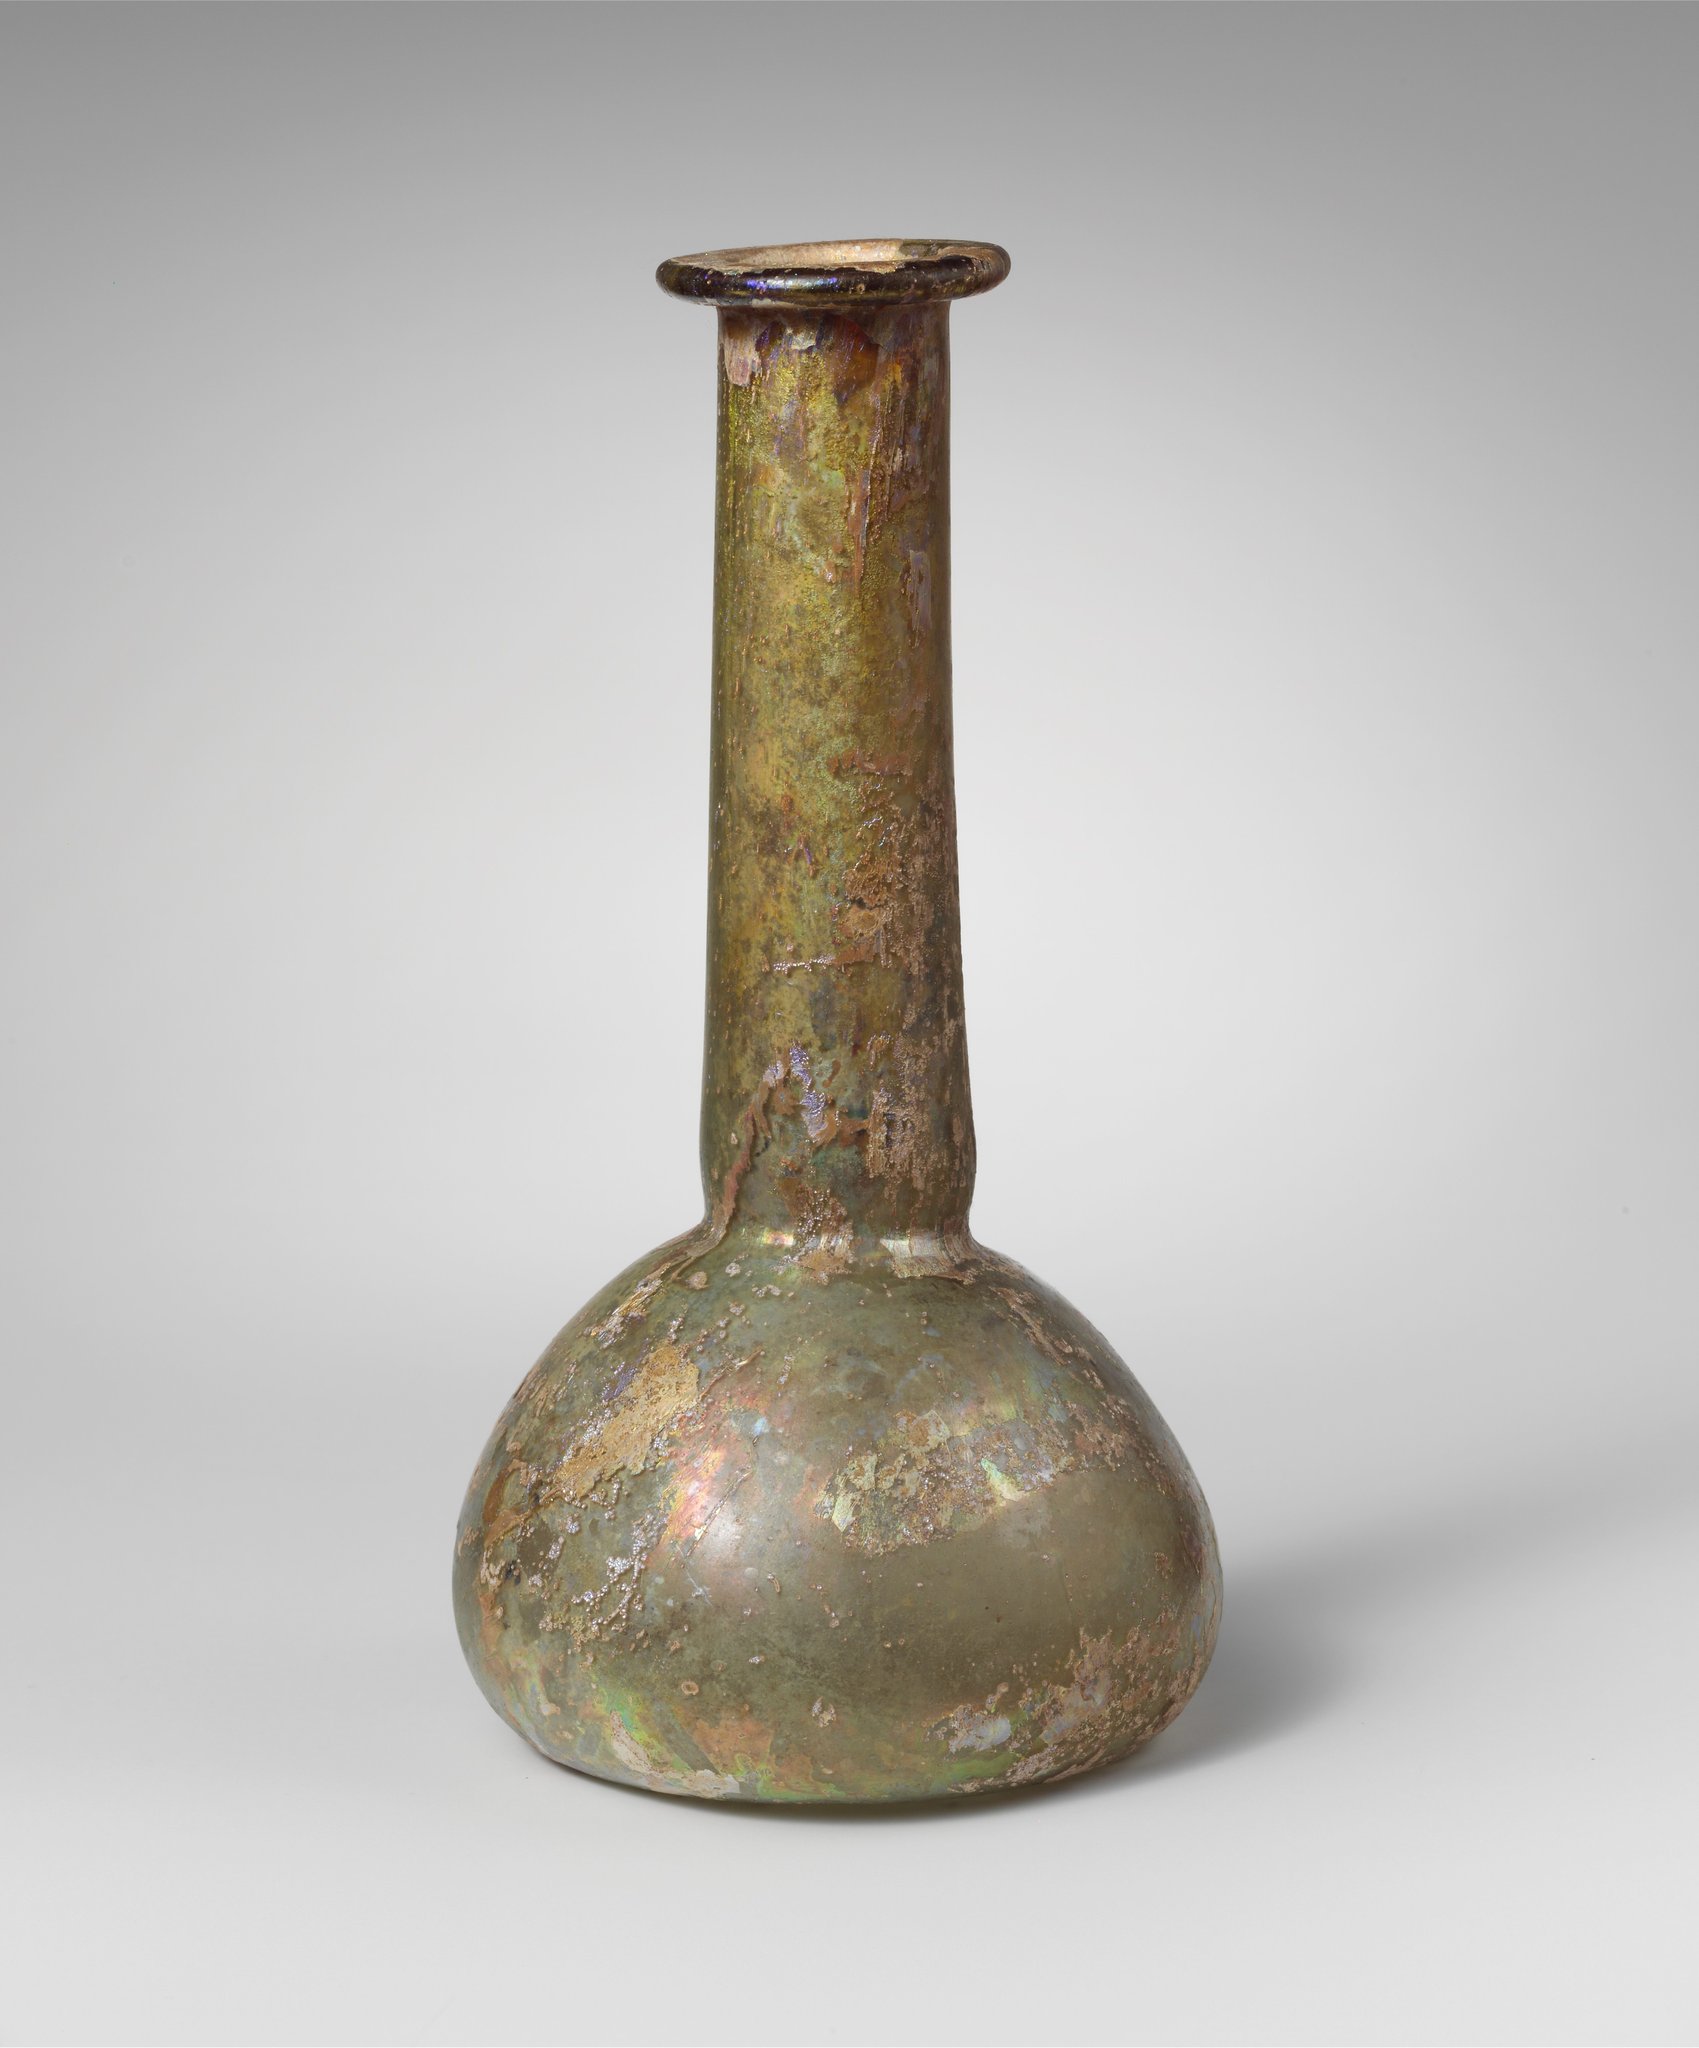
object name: perfume bottle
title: Glass perfume bottle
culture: roman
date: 101-300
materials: glass